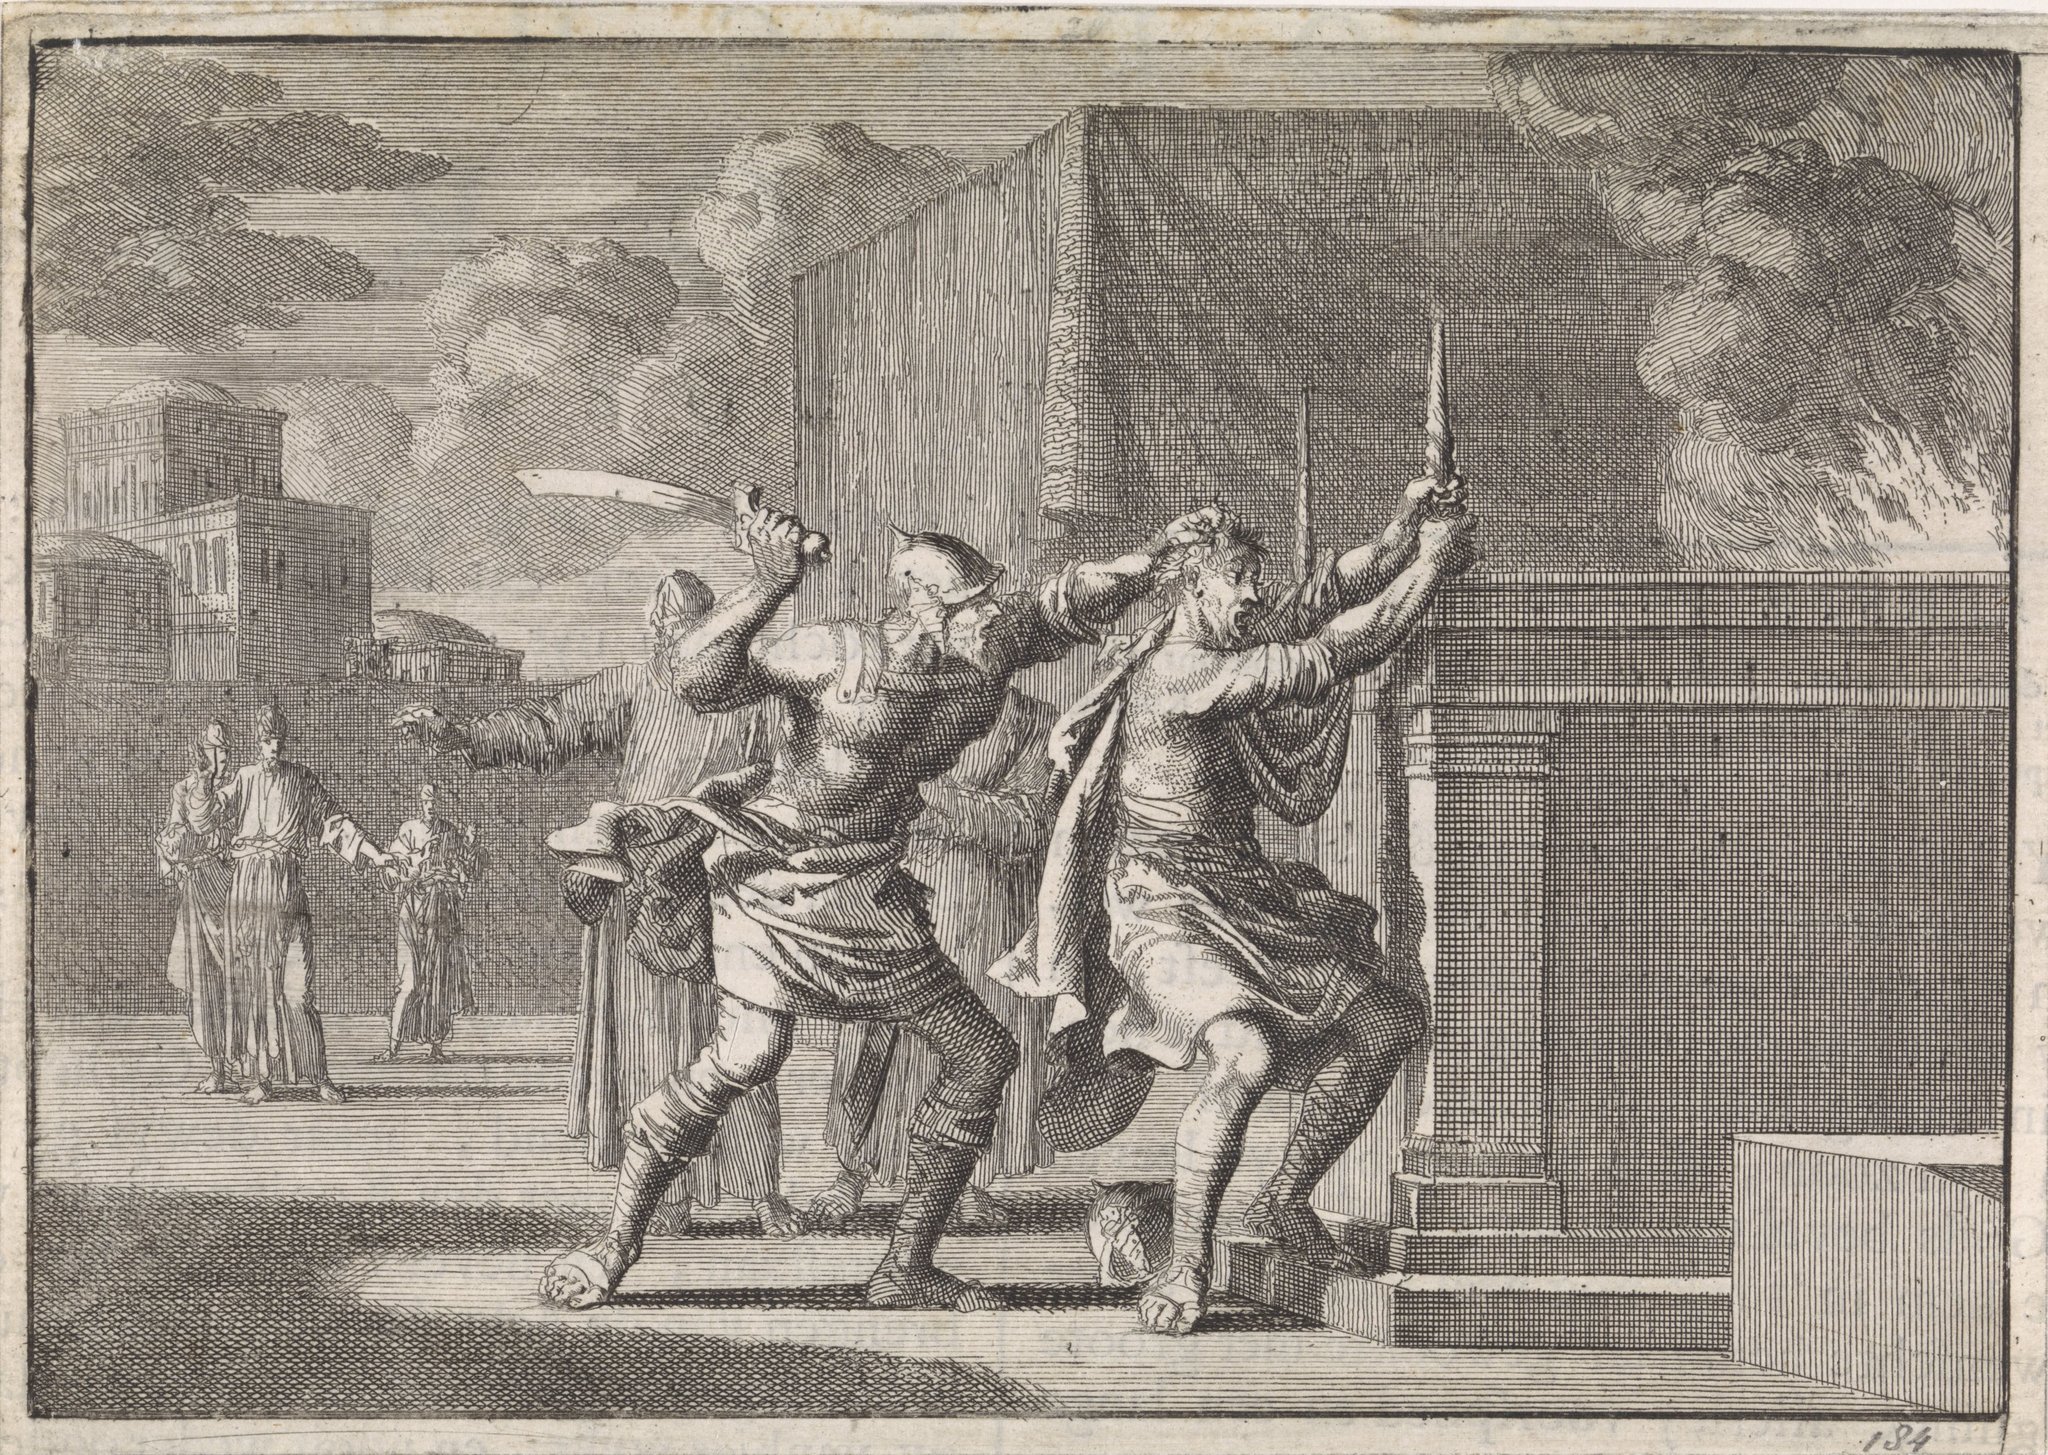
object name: print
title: Joab door Benaja gedood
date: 1704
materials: paper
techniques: etching, letterpress printing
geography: amsterdam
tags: joab killed by benaiah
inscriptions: collector's mark: Lugt 2228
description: Prent opgenomen in: Josephus, Flavius. Alle de Werken, 2 delen. Amsterdam: Pieter Mortier, 1704, dl. 1, p. 184.